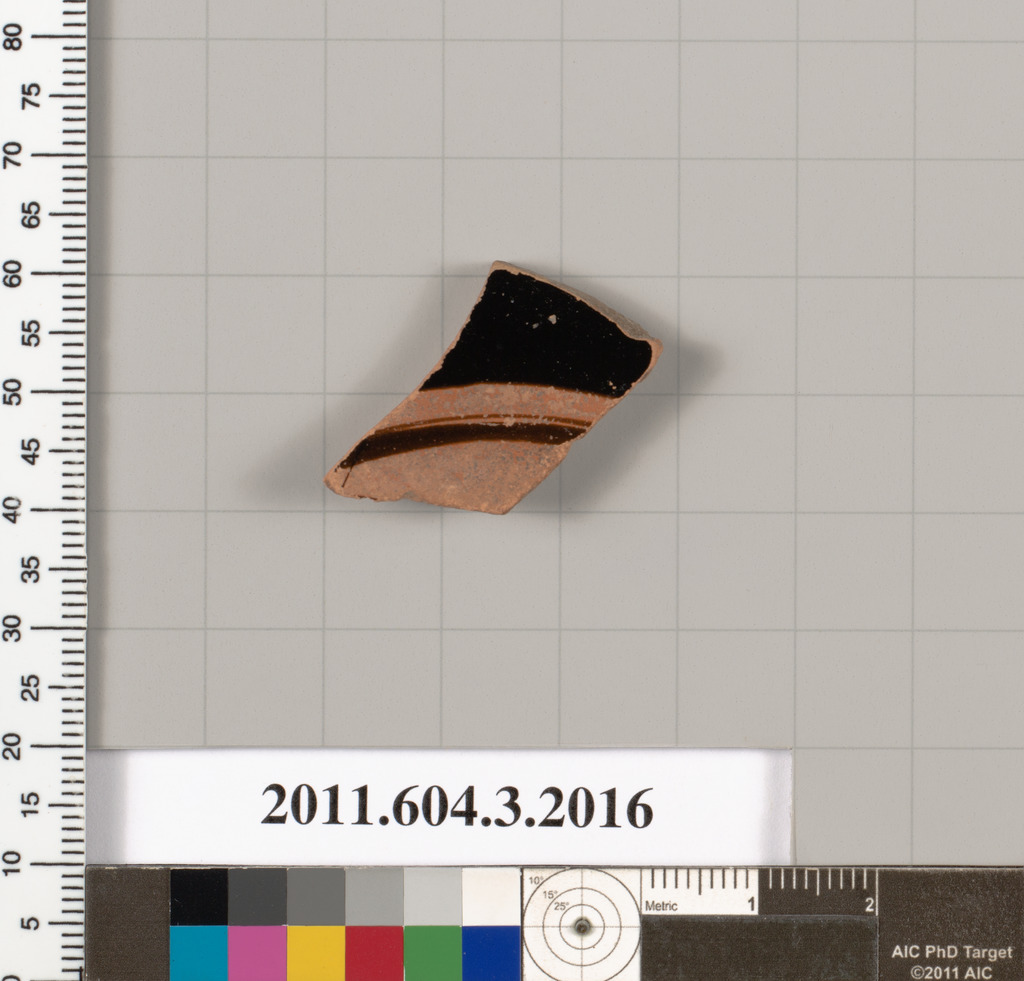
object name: kylix fragment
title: Terracotta fragment of a kylix (drinking cup)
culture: greek, attic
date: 550-526 BCE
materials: terracotta